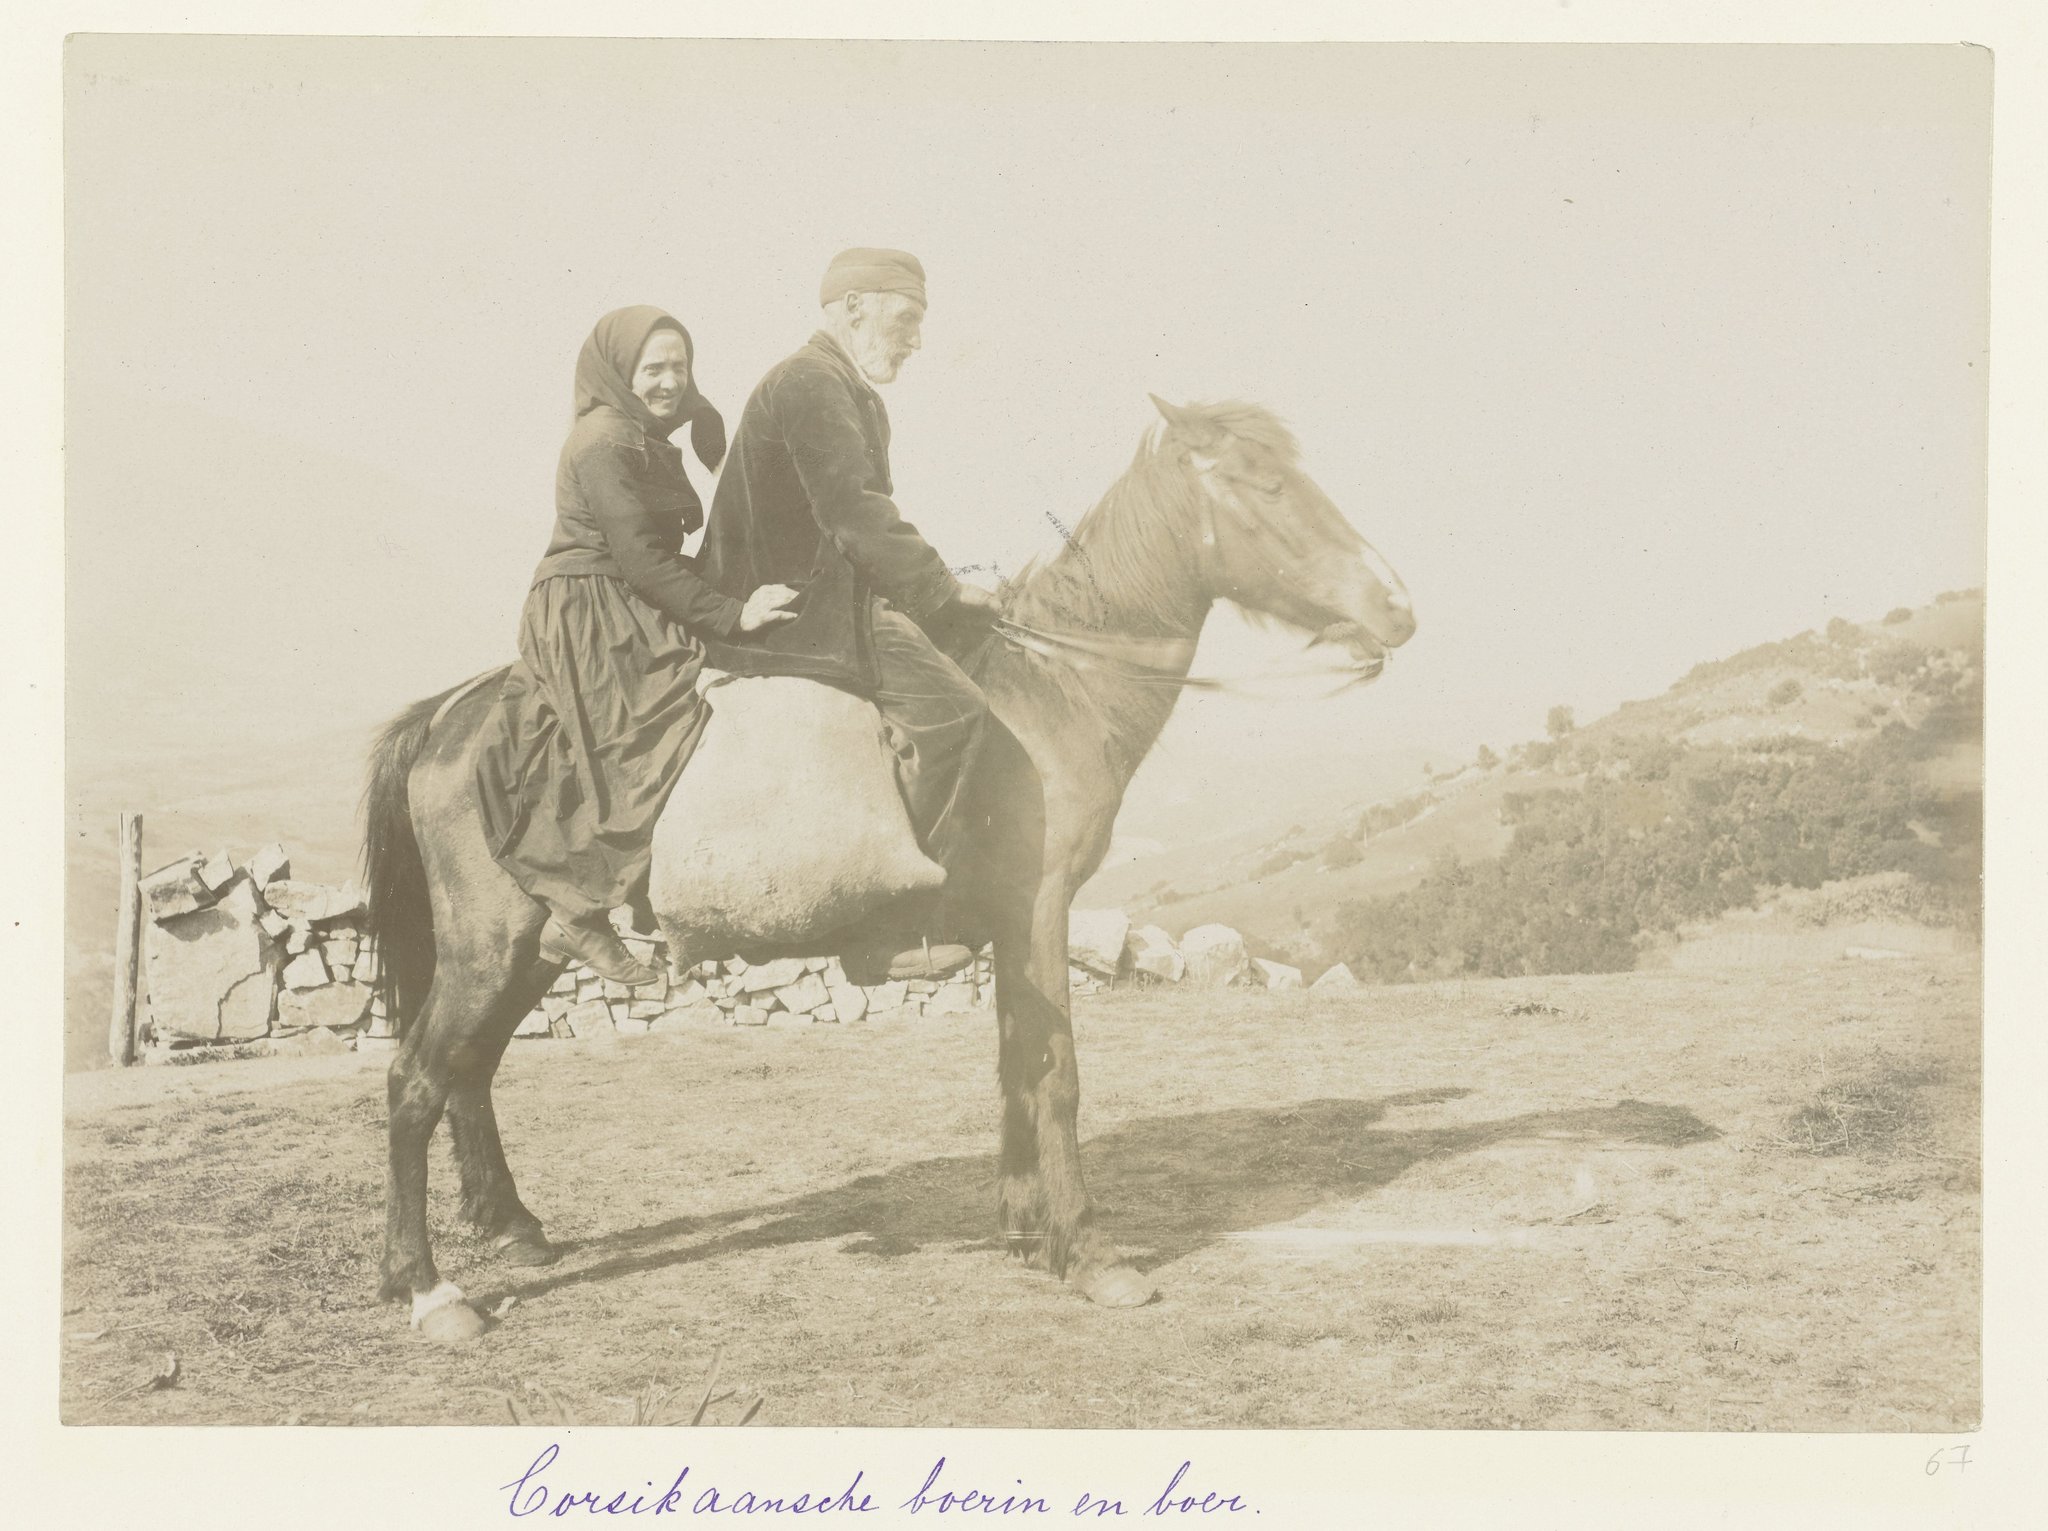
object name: photograph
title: Man en vrouw op paard op het Corsicaanse platteland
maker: henry pauw van wieldrecht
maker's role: fotograaf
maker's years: 1863-1912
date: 1886-1896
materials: cardboard, photographic support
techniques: albumen print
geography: corsica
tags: corsica